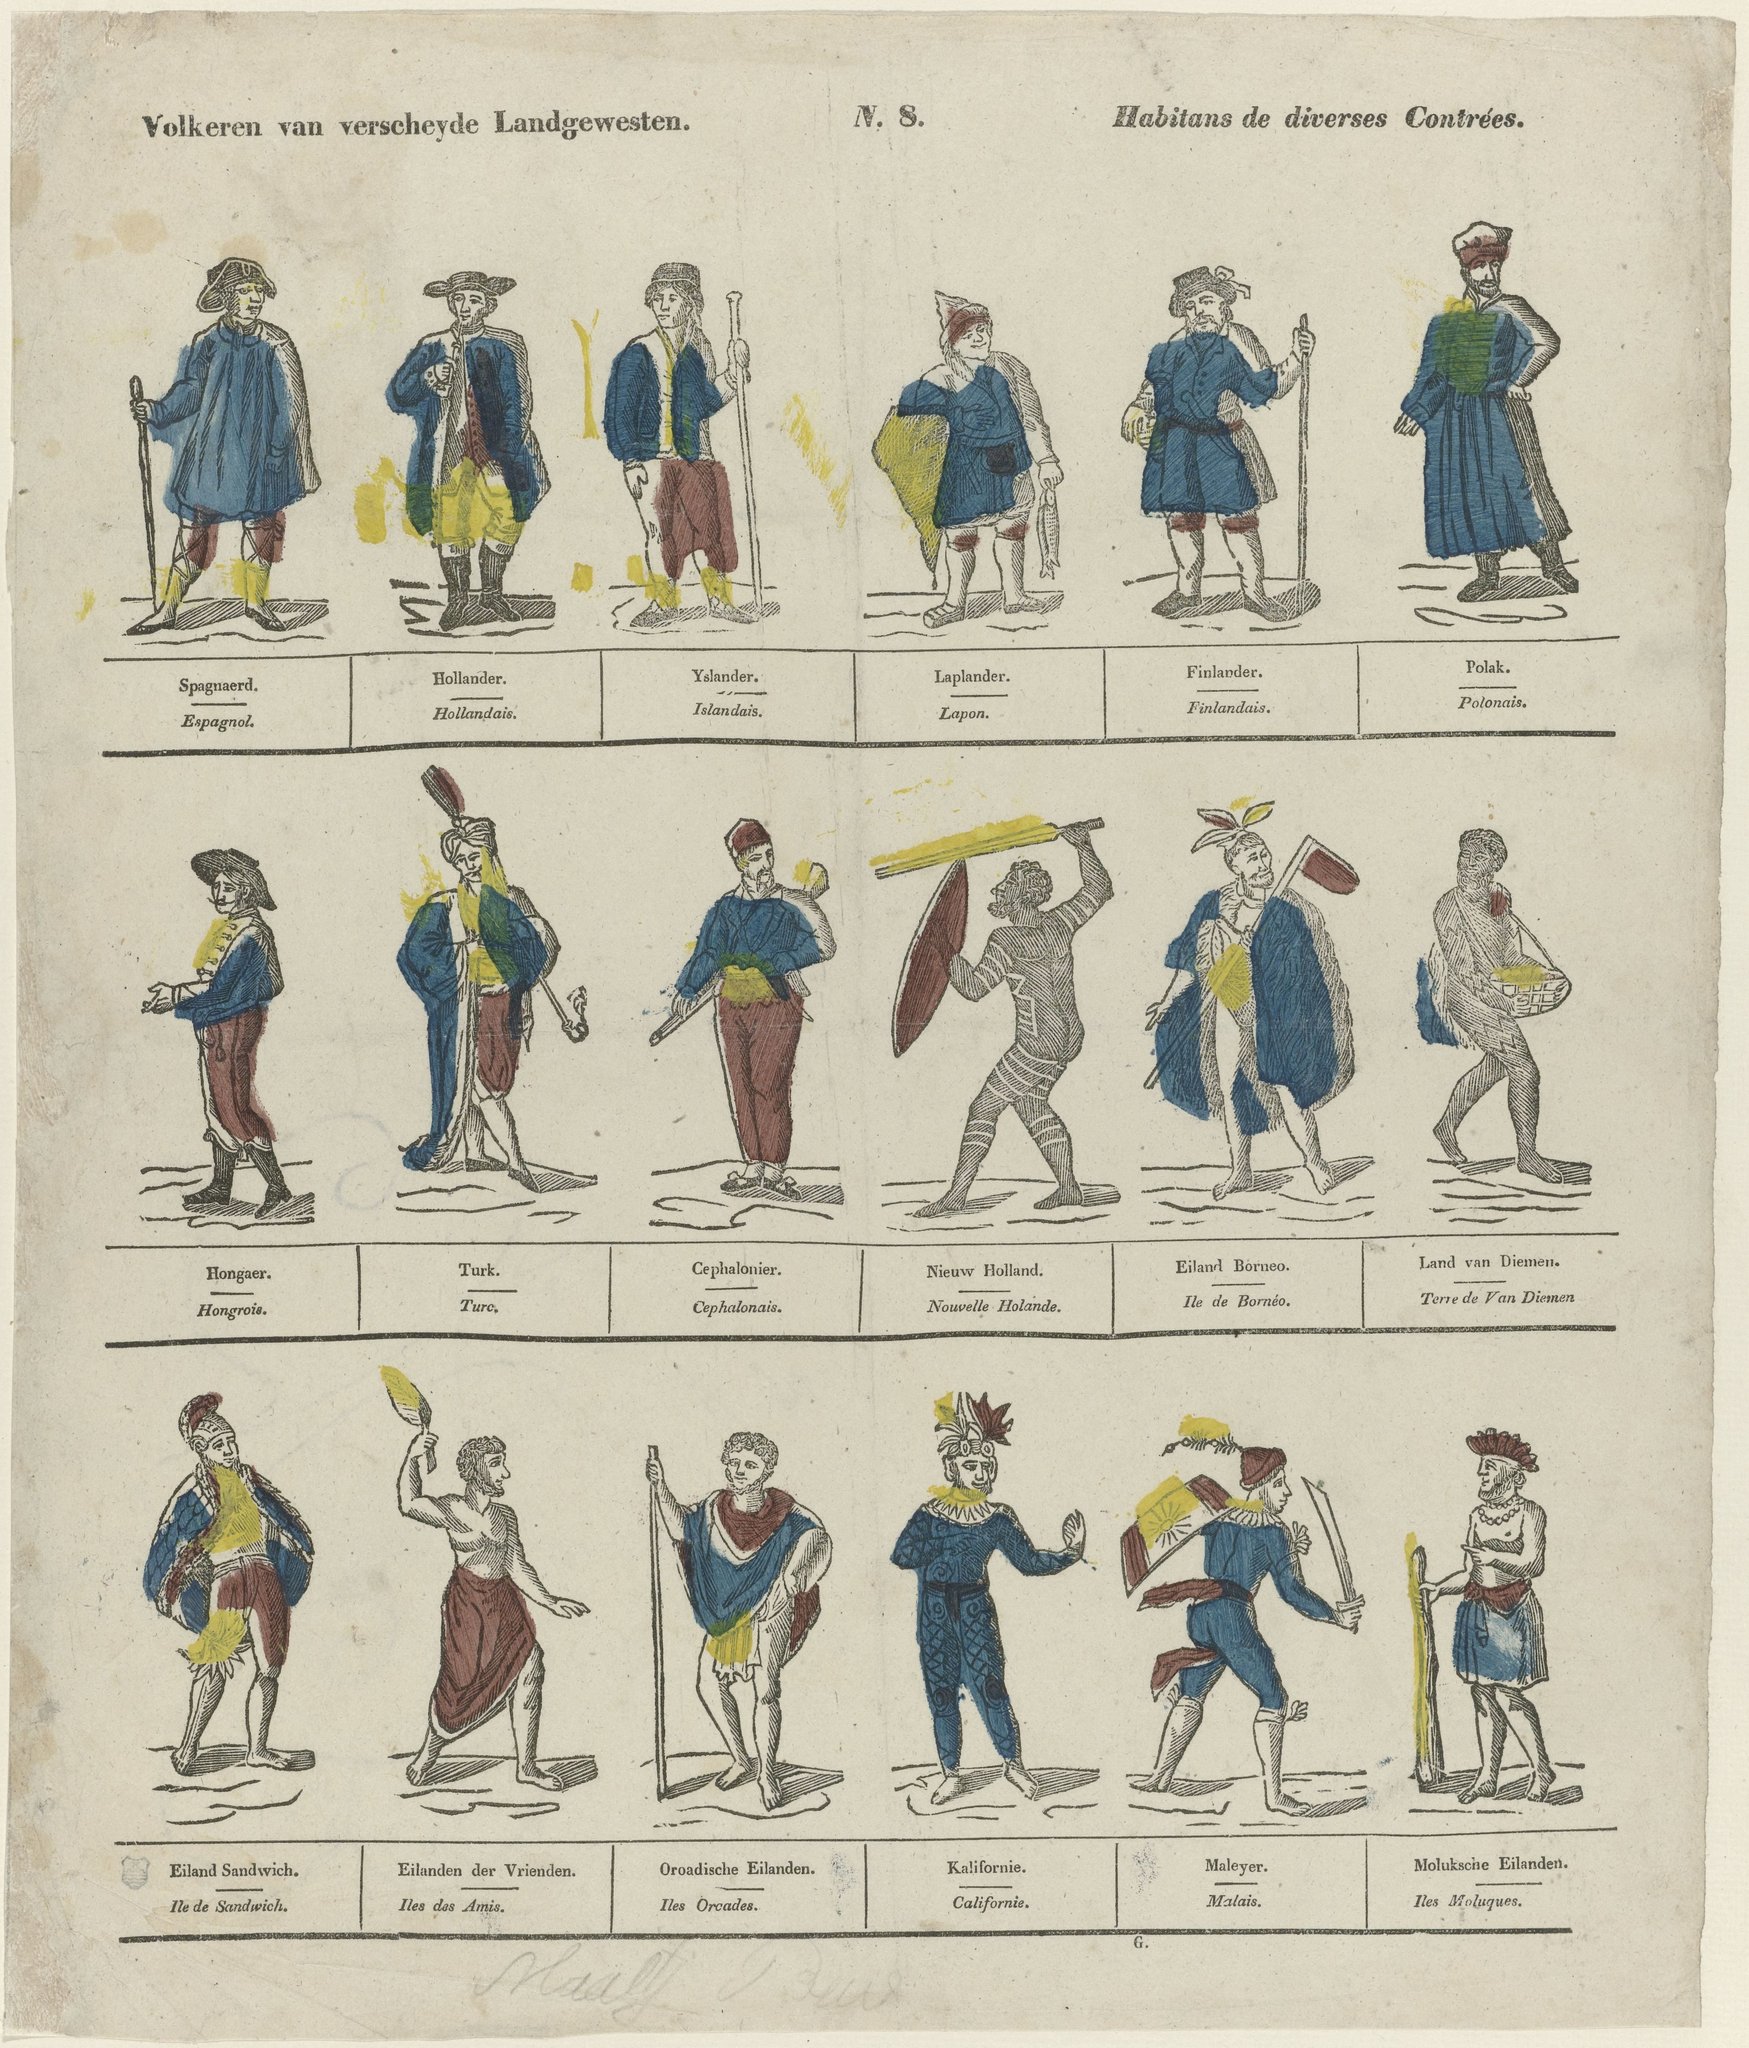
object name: print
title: Volkeren van verscheyde landgewesten / Habitans de diverses Contrées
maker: Anonymous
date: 1833-1856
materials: paper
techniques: colour, letterpress printing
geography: turnhout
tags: human races; peoples; nationalities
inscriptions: collector's mark: Lugt 2760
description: Blad met 3 horizontale rijen met in totaal 18 voorstellingen van mensen uit verschillende landen, zoals een Hollander, een Laplander, een Turk en een Pool. Onder elk figuur een onderschrift in het Nederlands en in het Frans. Genummerd midden boven: N. 8.